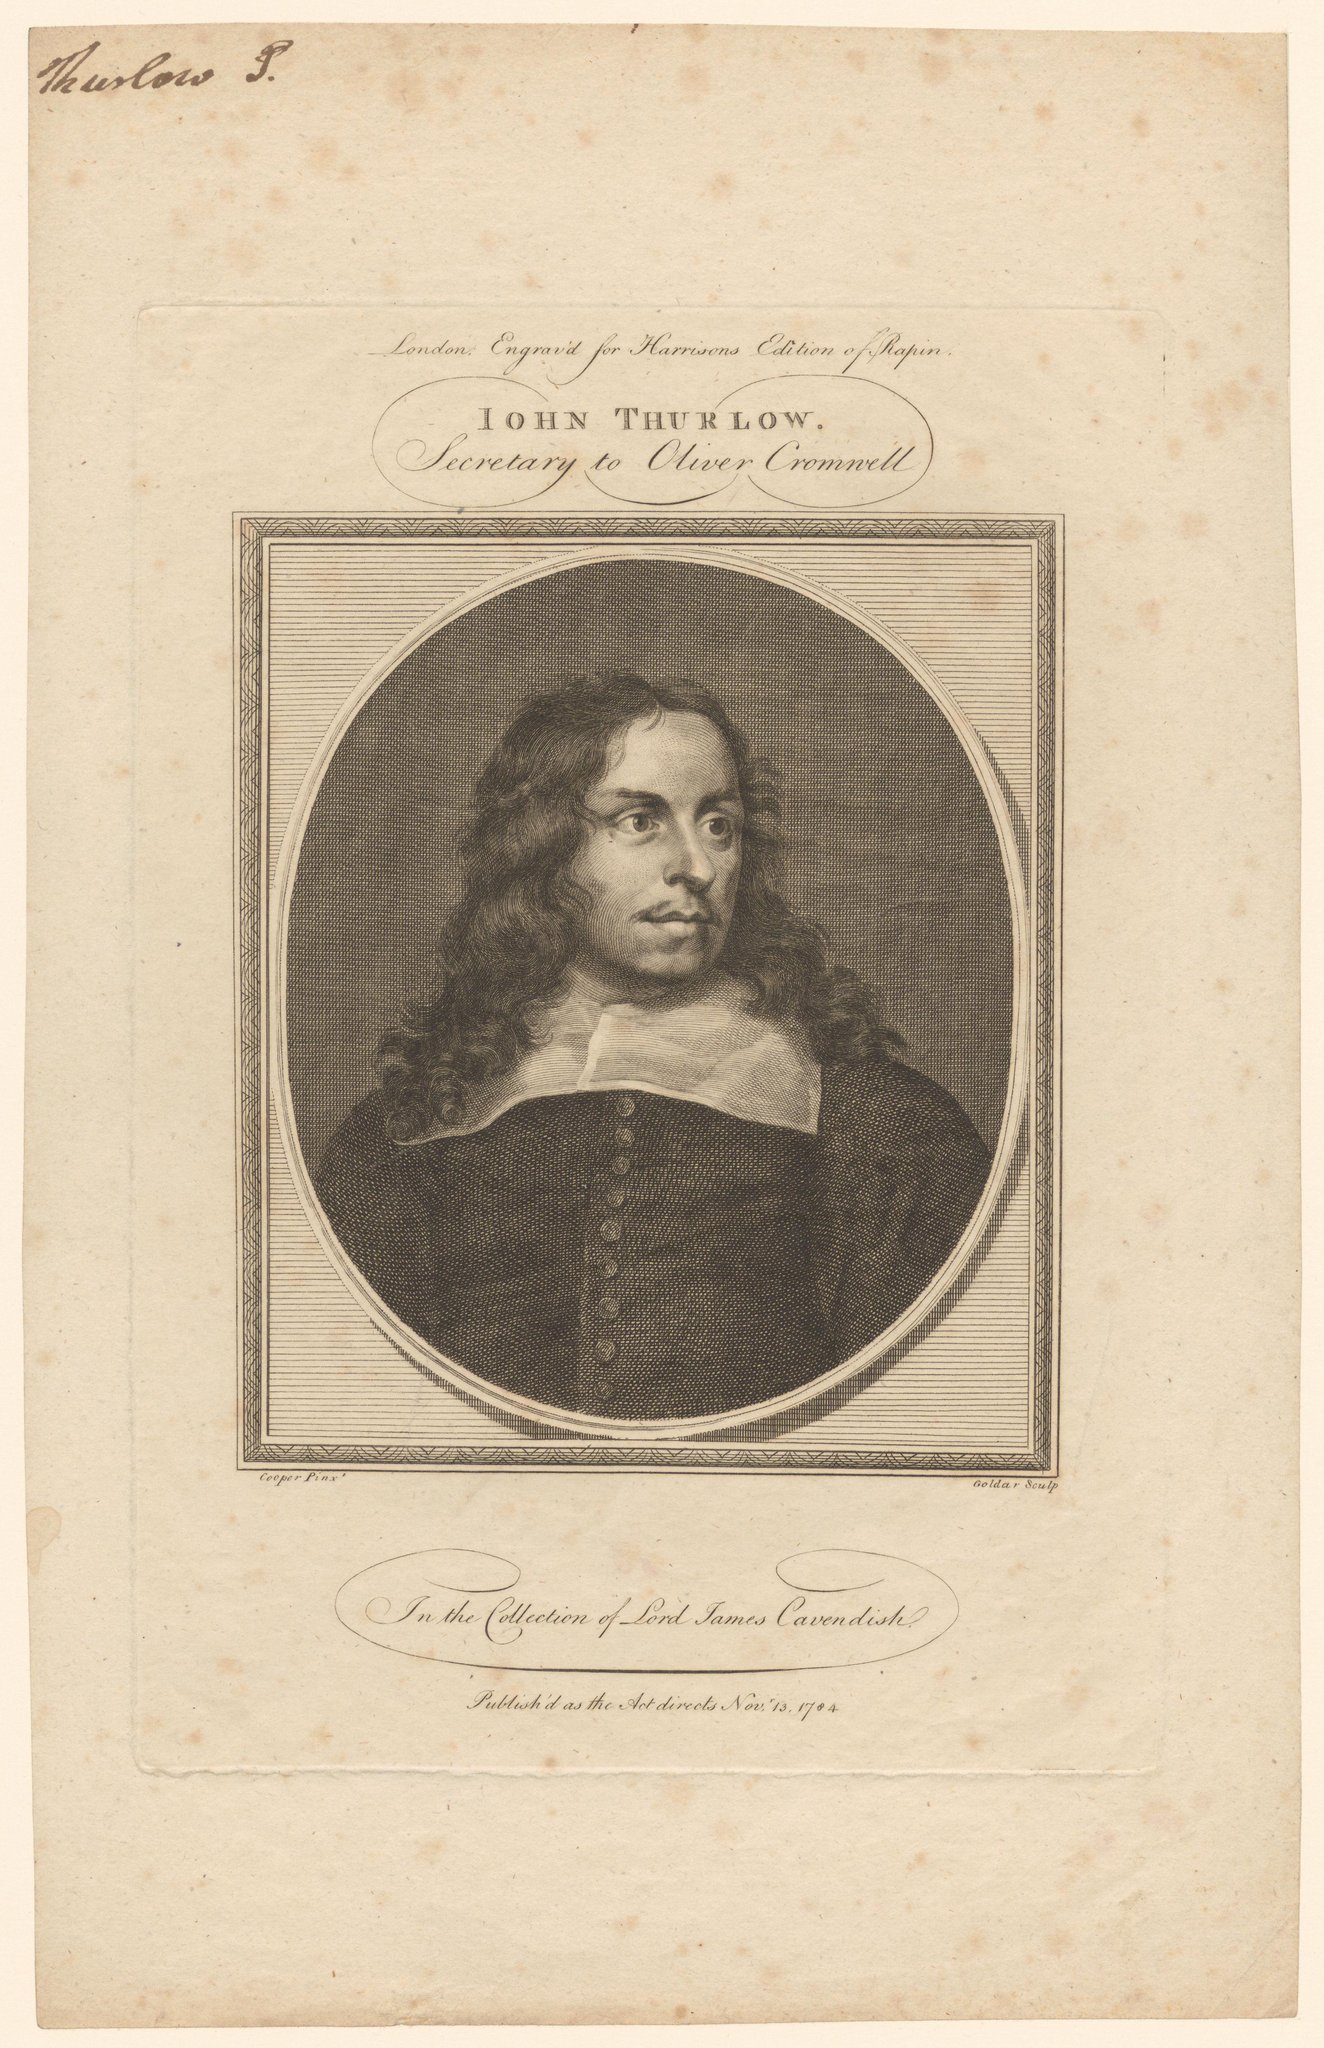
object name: print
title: Portret van John Thurloe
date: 1784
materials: paper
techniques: engraving, etching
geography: london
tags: historical persons, politician, e.g. party leader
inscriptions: collector's mark: Lugt 2228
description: Prent is gebruikt in: Rapin, Paul de. History of England. [Vertaald uit het Frans door] Nicolas Tindal. Londen: John Harrison, 1784.